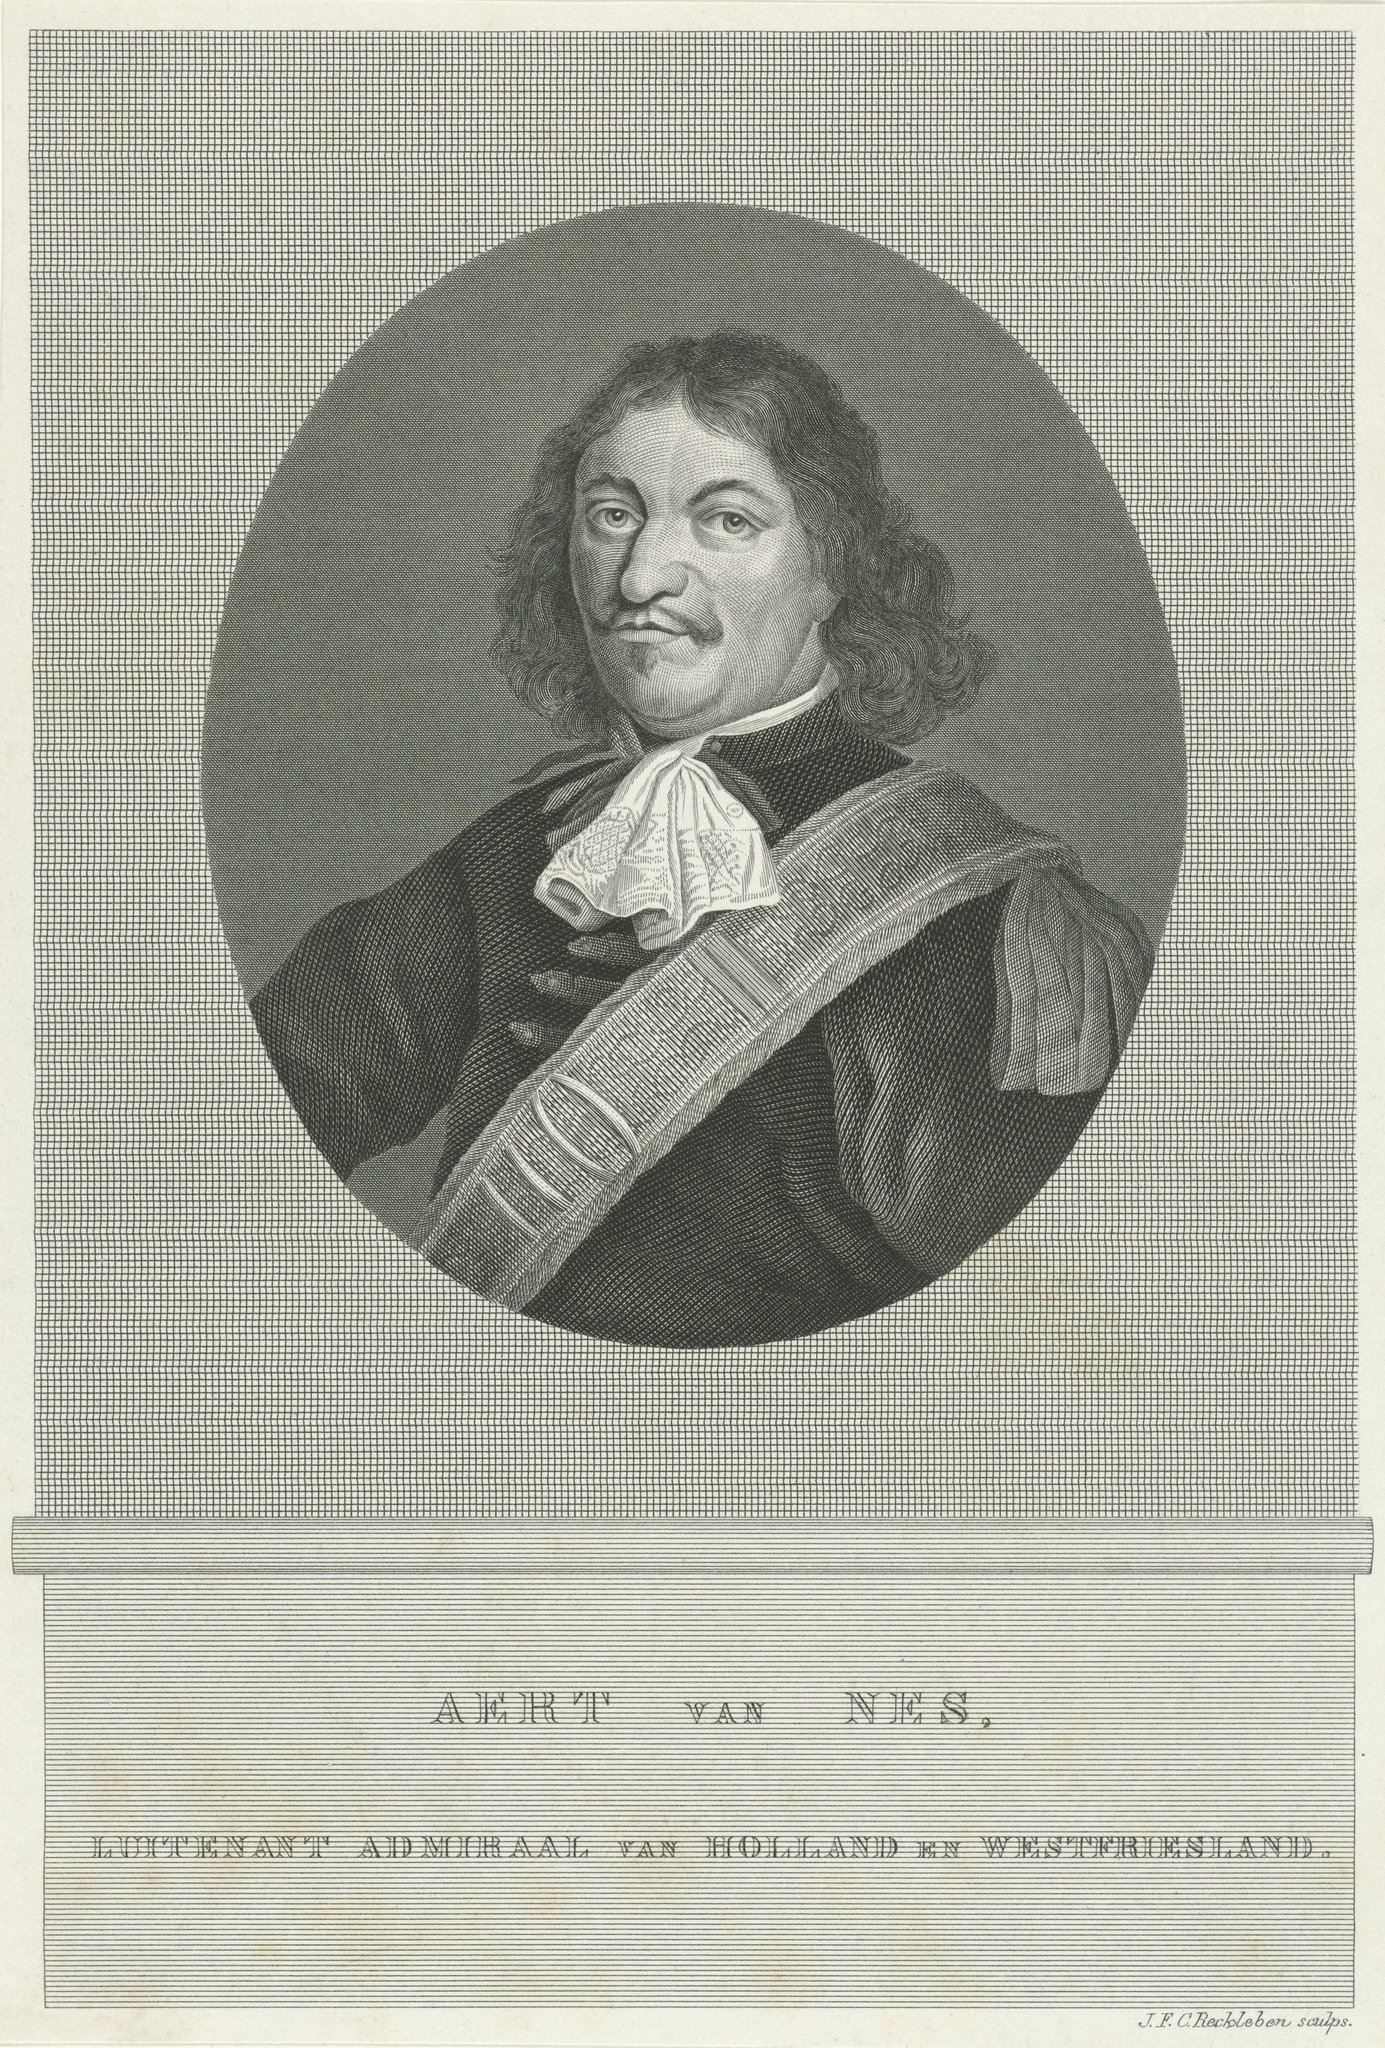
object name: print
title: Portret van Aert Jansz. van Nes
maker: jan frederik christiaan reckleben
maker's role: print maker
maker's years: 1819-1879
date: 1877-1879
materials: paper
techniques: engraving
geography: amsterdam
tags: rotterdam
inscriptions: collector's mark: Lugt 2228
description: Illustratie in: Arend, Johannes Pieter. Algemeene geschiedenis des vaderlands van de vroegste tijden tot op heden. 5 delen, Amsterdam: Schleijer, J.F. 1840-1884, dl. 4.1, p. 784.